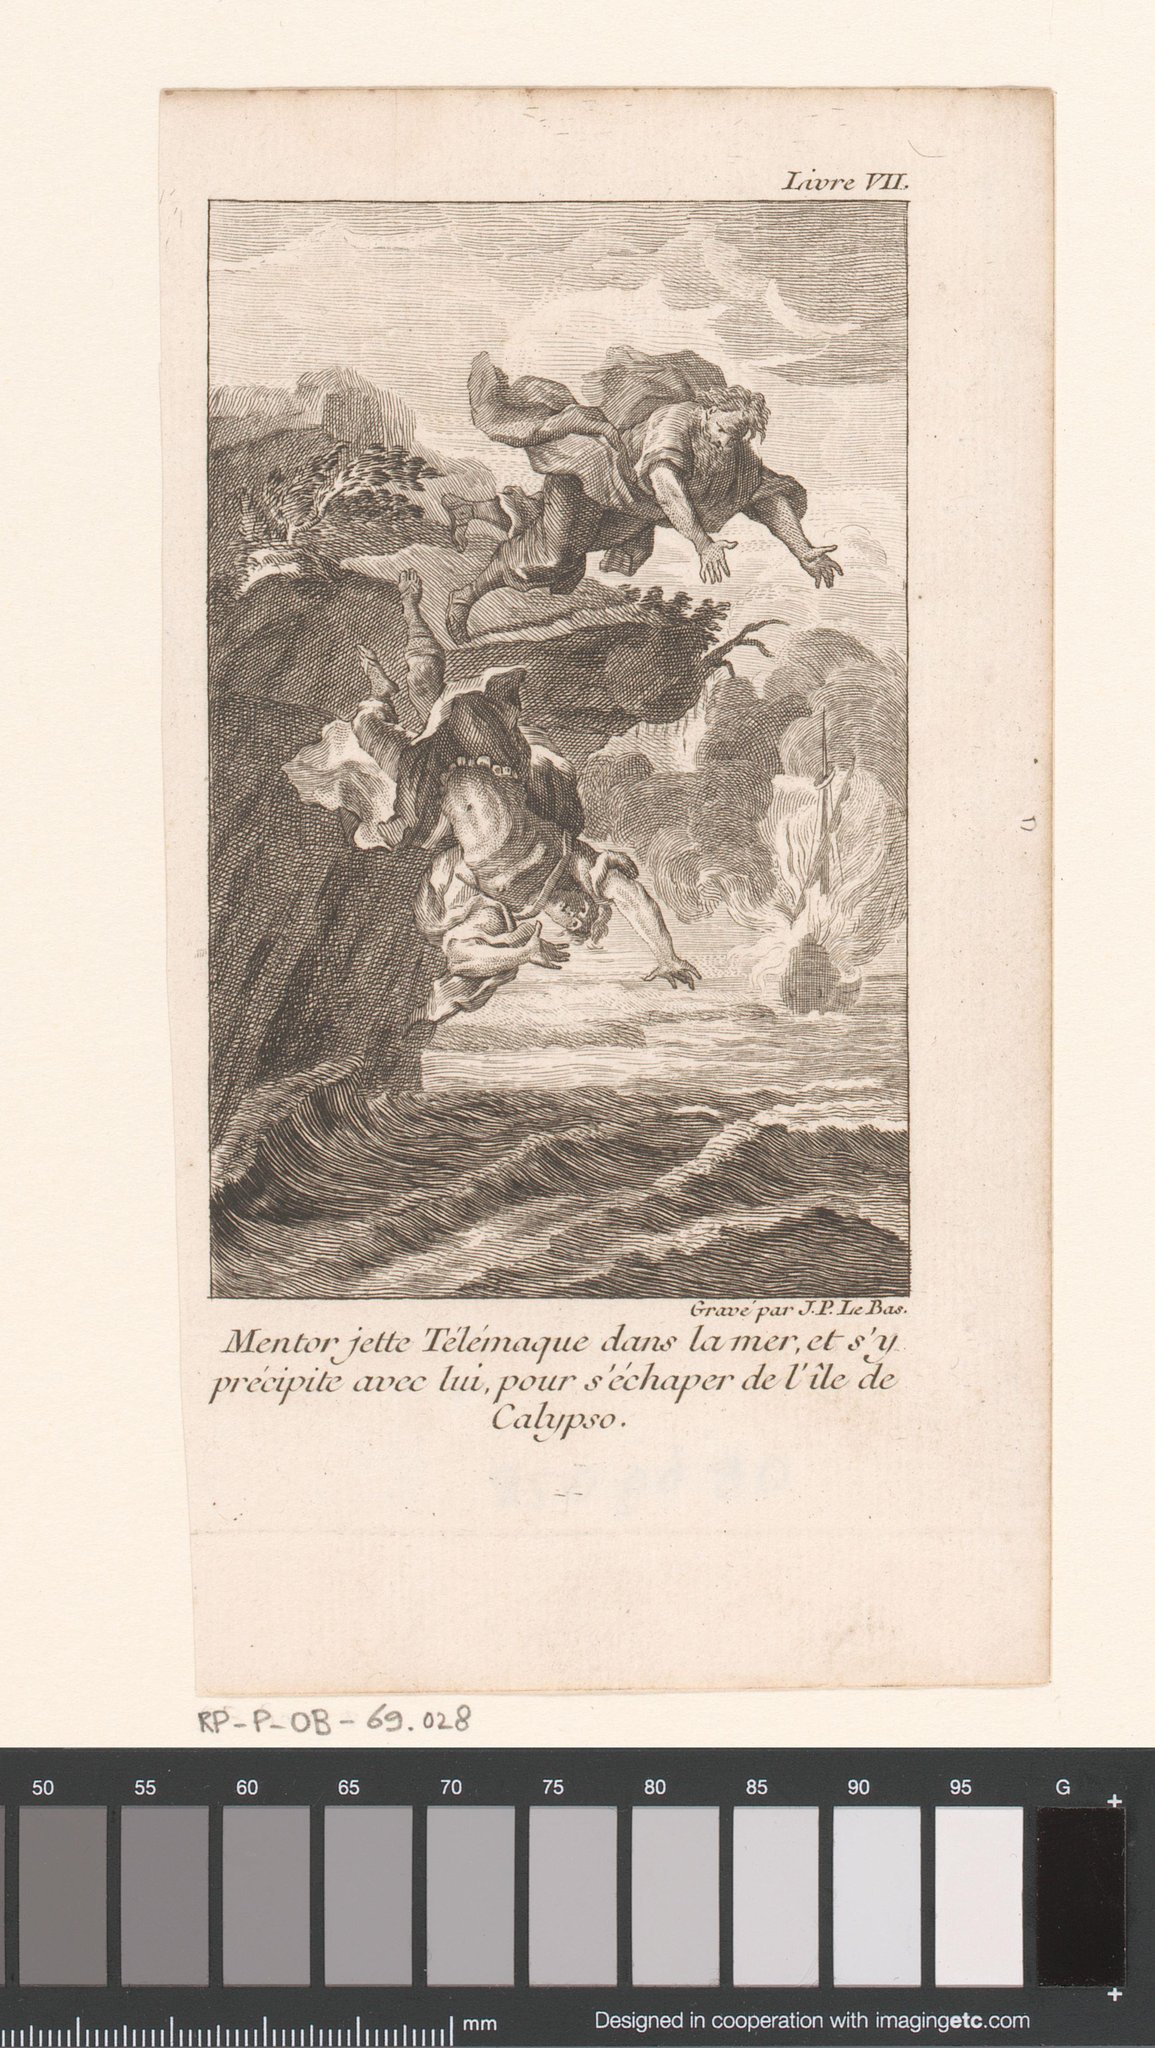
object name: print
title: Mentor werpt Telemachus in zee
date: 1755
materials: paper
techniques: etching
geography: paris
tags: (fenelon, telemachus) specific works of literature (with author, title), (story of) telemachus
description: Prent uit: Fénélon, François. Les Aventures de Télémaque. Parijs: Théodore Legras, 1755.